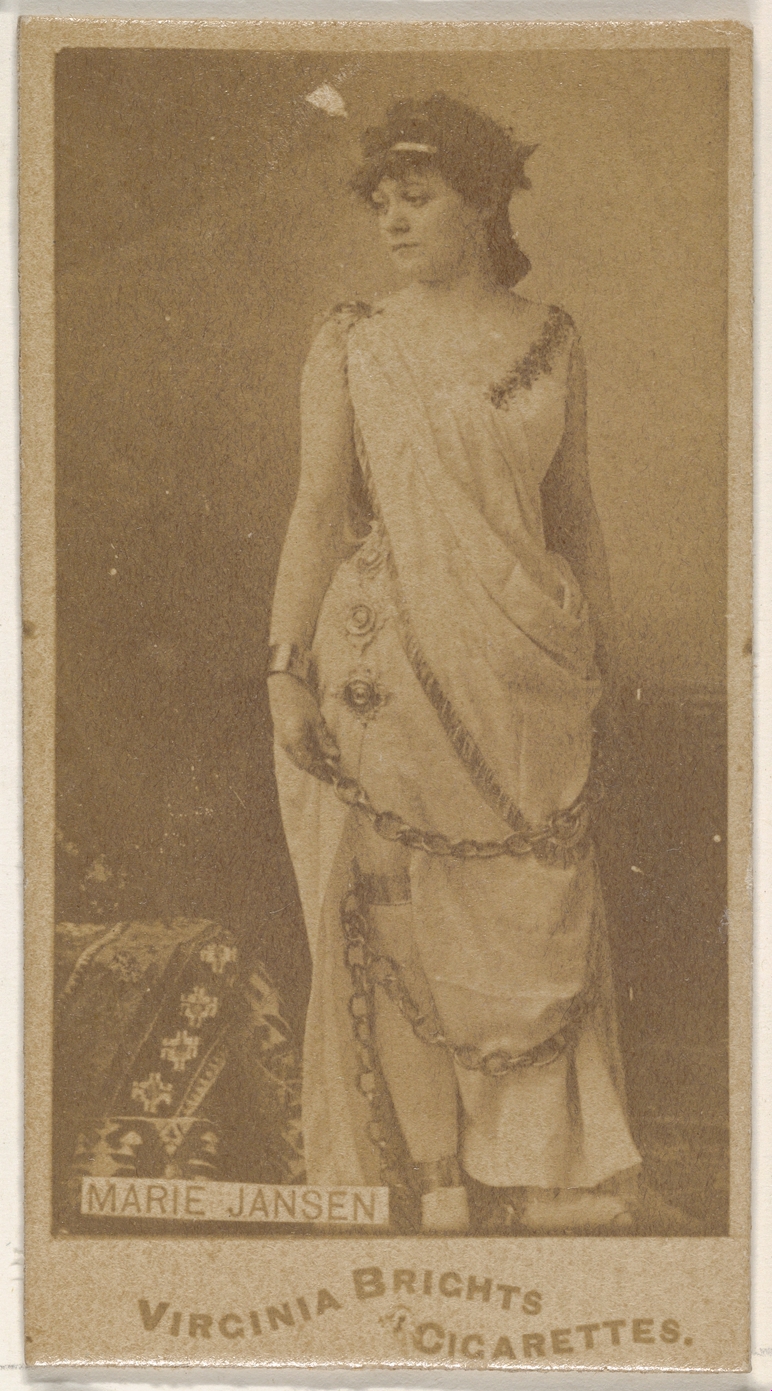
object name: photograph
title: Marie Jansen, from the Actors and Actresses series (N45, Type 1) for Virginia Brights Cigarettes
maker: allen & ginter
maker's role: publisher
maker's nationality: american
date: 1888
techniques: albumen silver print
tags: portraits,women,actresses